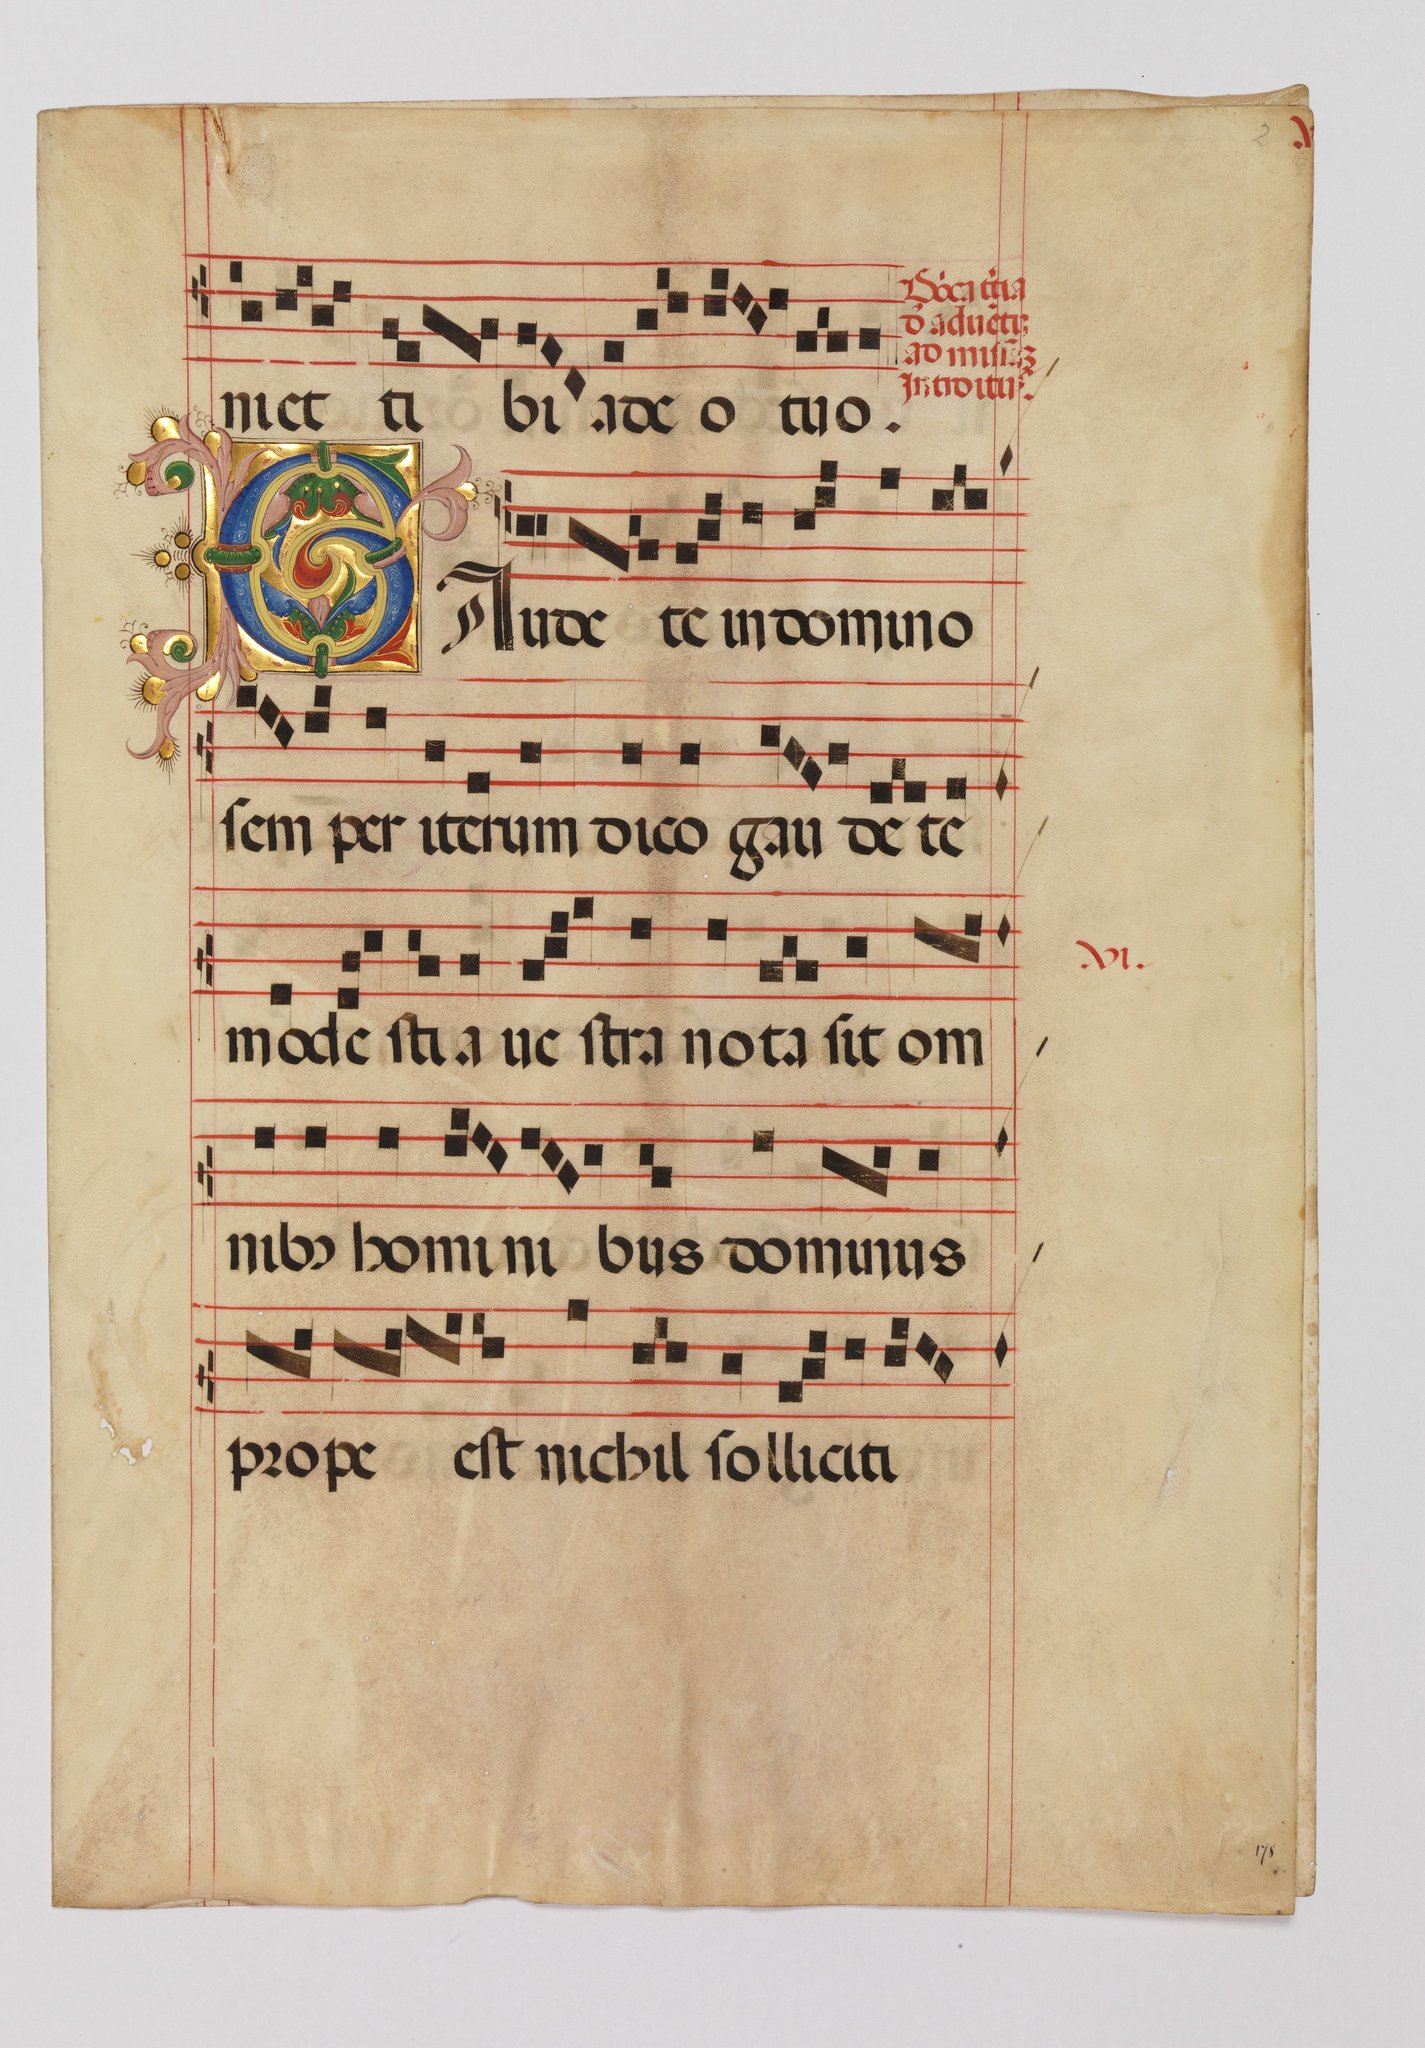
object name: choir book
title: Bifolium with Foliated Initial C, from a Gradual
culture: italian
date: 1451-1500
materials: gold, ink, parchment, paint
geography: italy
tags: music